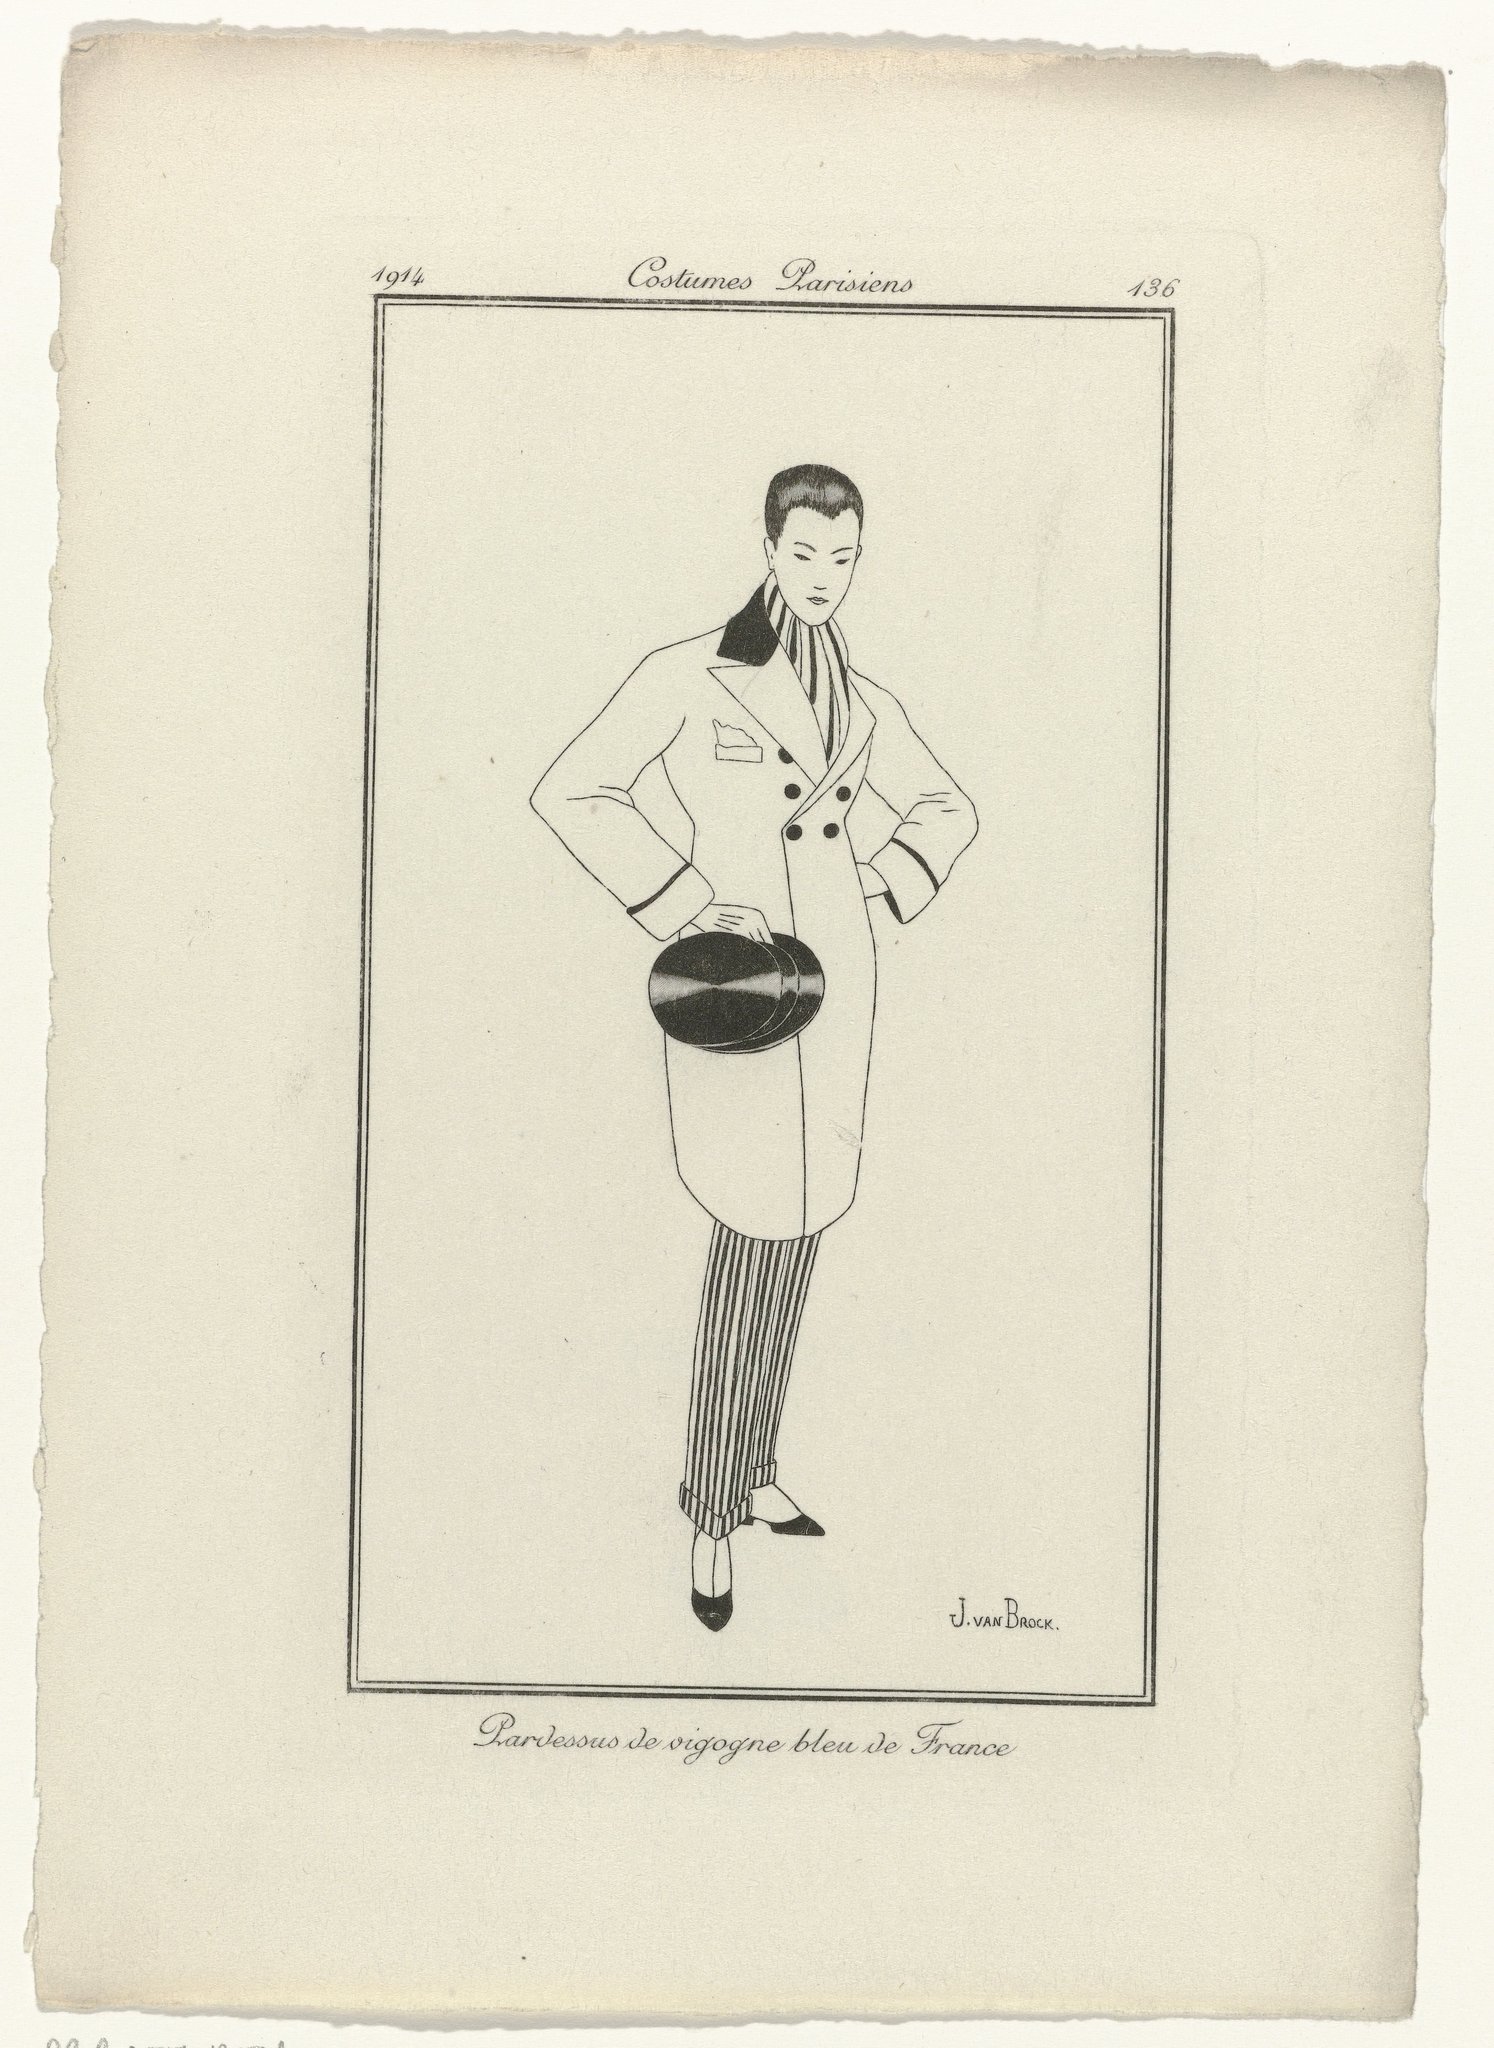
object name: fashion print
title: Journal des Dames et des Modes, Costumes Parisiens, 1914, No. 136 : Pardessus de vigogn (...)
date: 1914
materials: paper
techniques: engraving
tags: trousers, breeches, etc. (pantalon) (+ men's clothes), coat: overcoat (+ men's clothes), fashion plates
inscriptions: caption: ‘Pardessus de vigogne bleu de France’, title: ‘Costumes Parisiens’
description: Man gekleed in een pardessus van blauwe vigogne-wol op een gestreepte lange broek. Hoge hoed in de hand. Proefdruk van een prent uit het modetijdschrift Journal des Dames et des Modes (1912-1914).